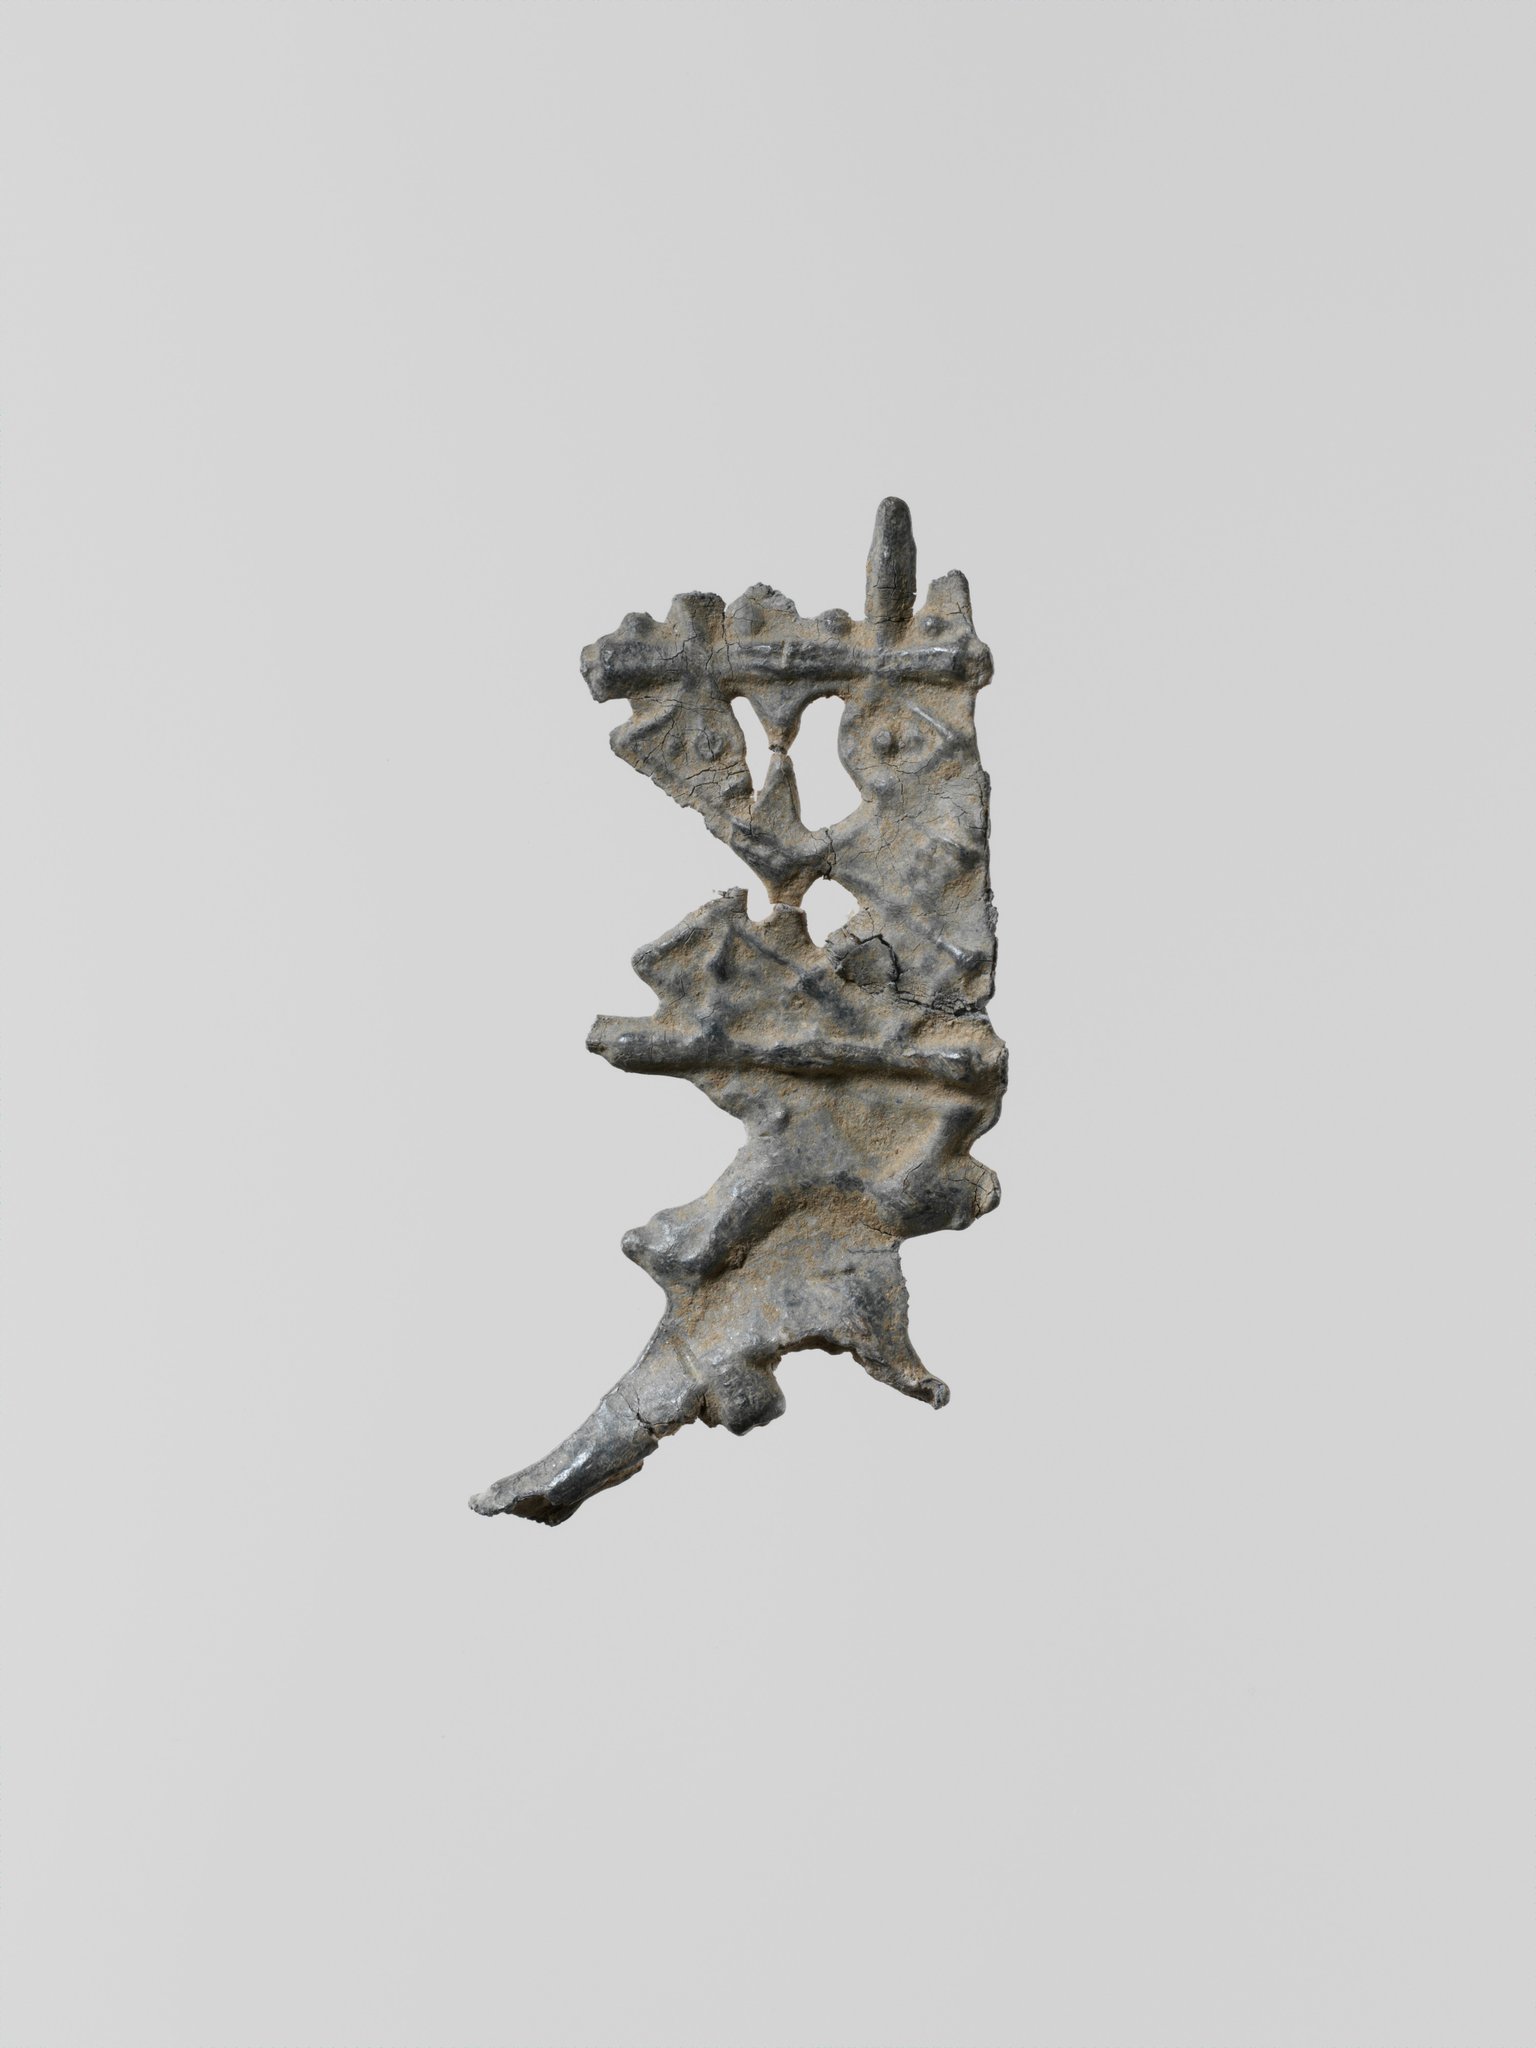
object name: ornament, 14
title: Ornaments, 14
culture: greek, laconian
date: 7000-30 BCE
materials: lead